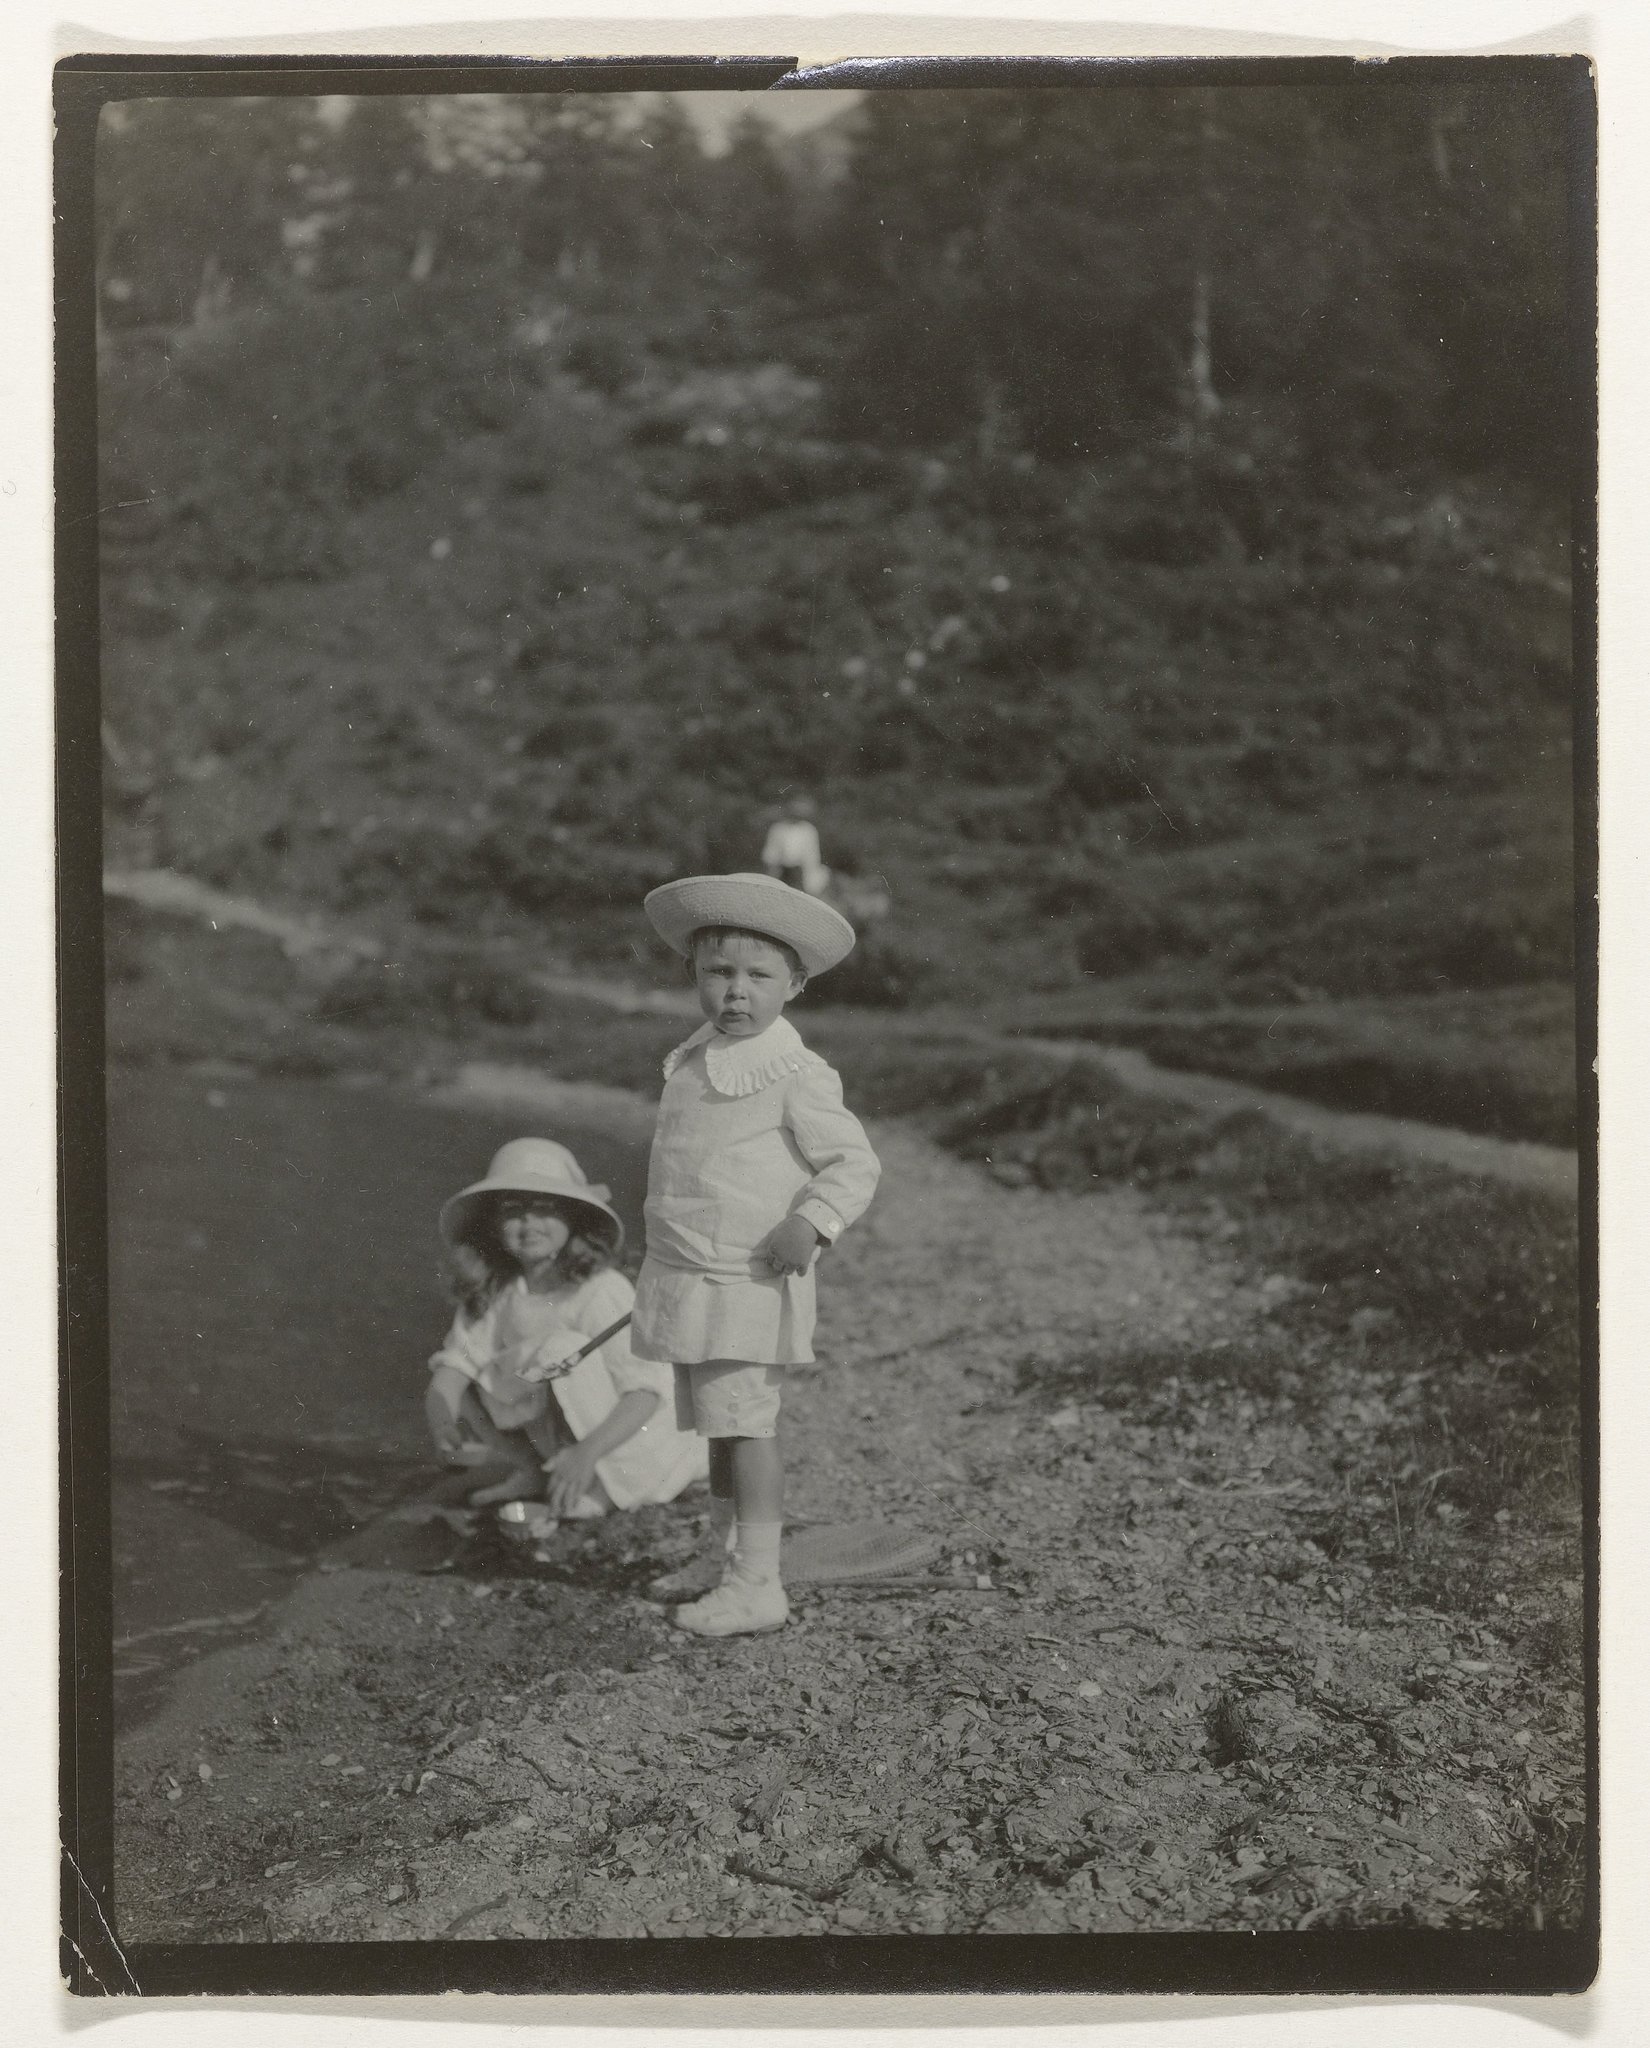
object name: photograph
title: Twee kinderen in een landschap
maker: Anonymous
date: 1900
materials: paper, photographic support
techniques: gelatin silver print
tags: boy (child between toddler and youth), girl (child between toddler and youth)